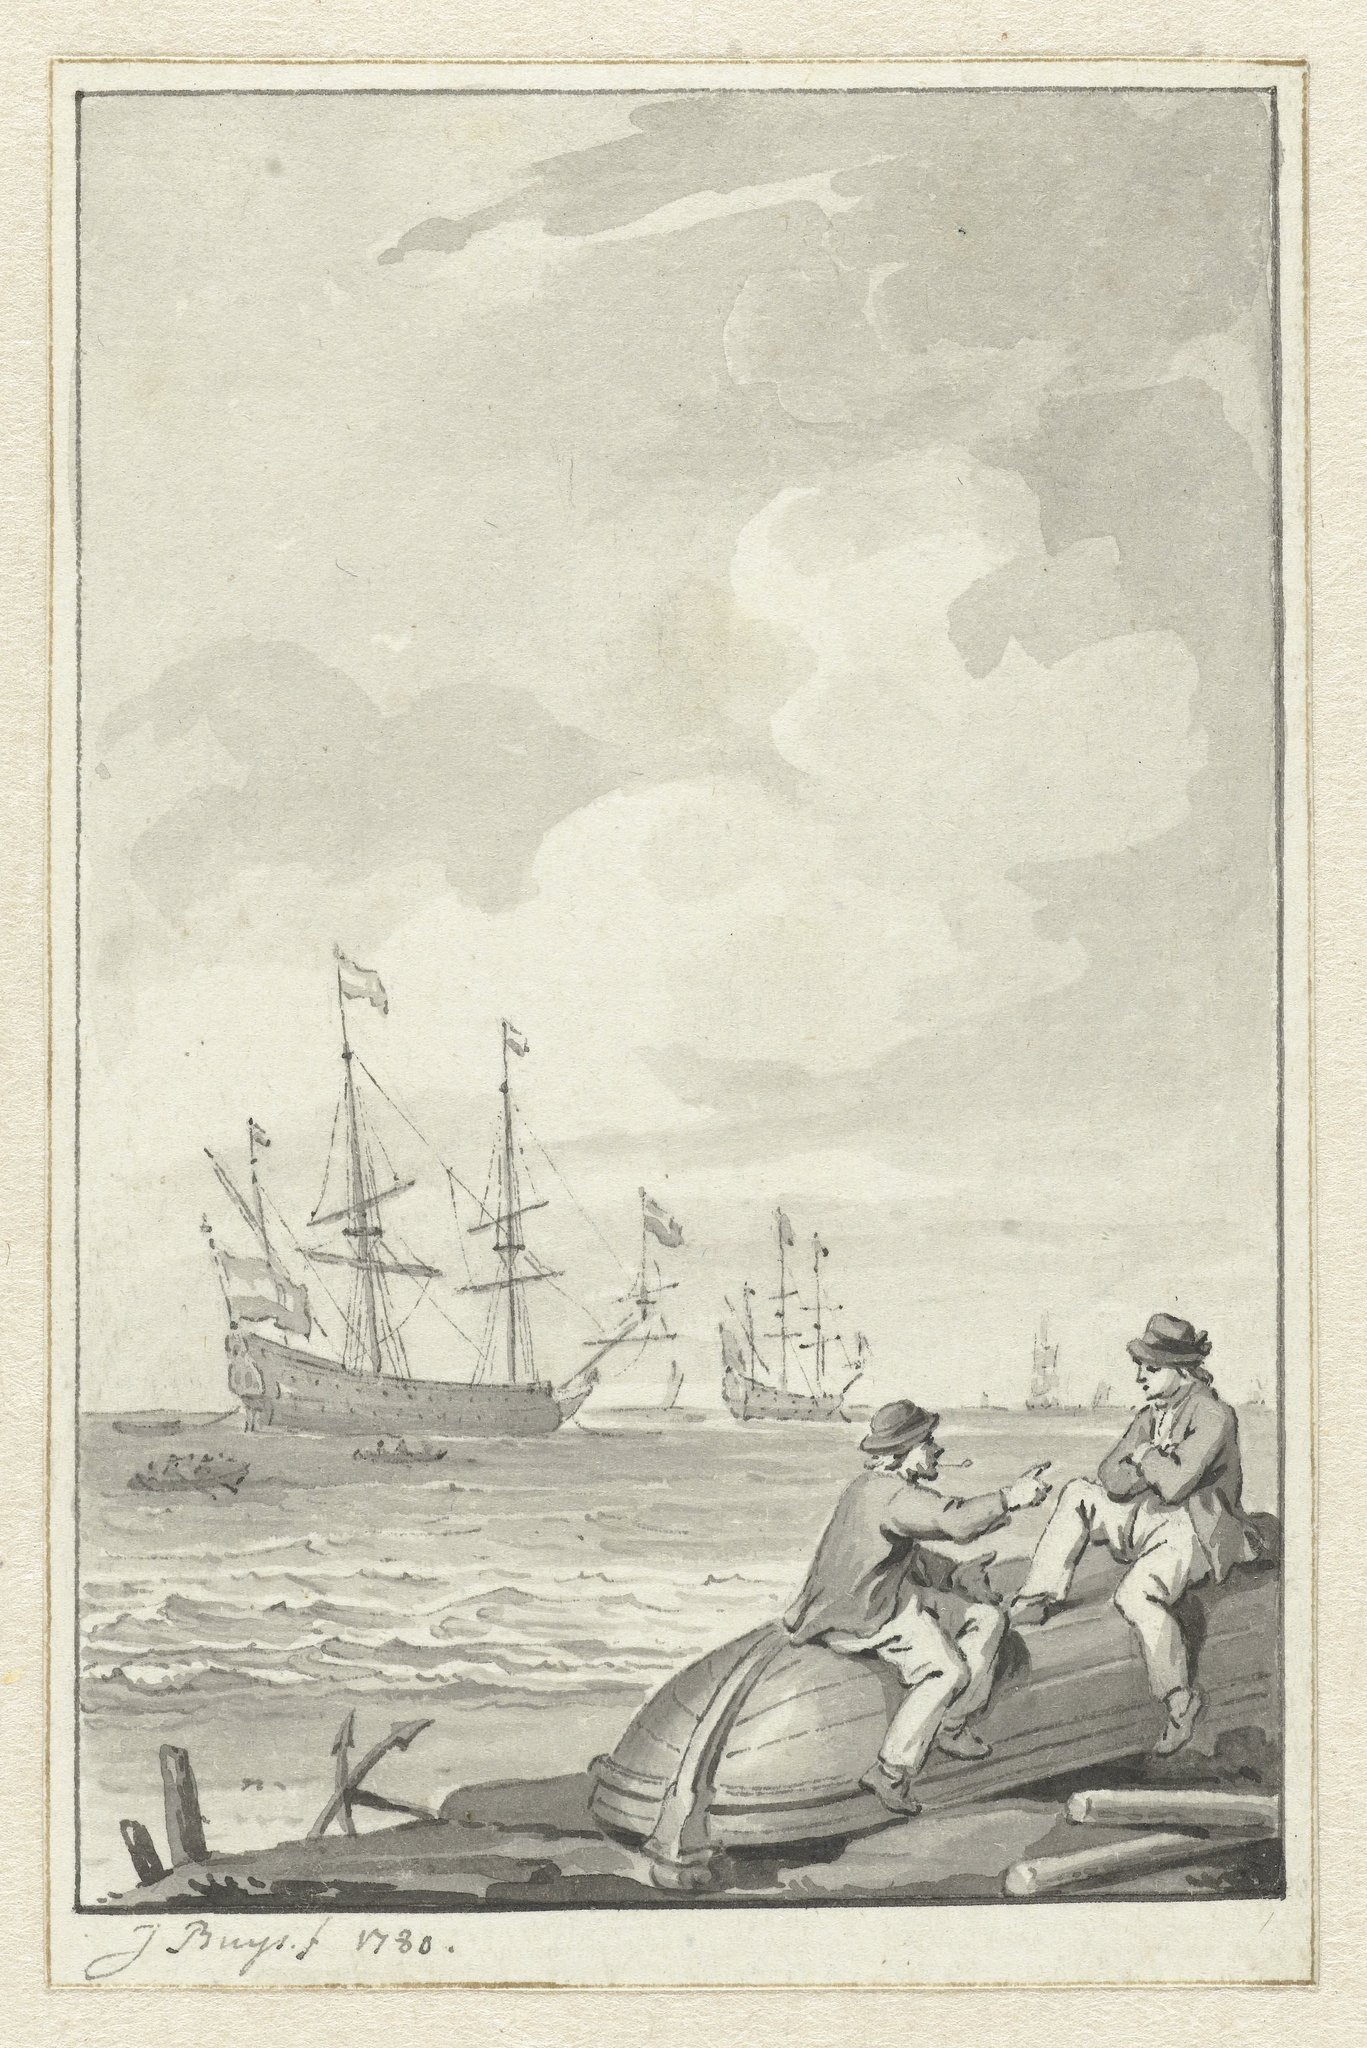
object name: design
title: Zeegezicht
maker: jacobus buys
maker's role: draughtsman, print maker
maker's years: 1724-1801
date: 1780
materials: ink, paper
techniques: brush, pen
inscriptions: date: ‘1780’